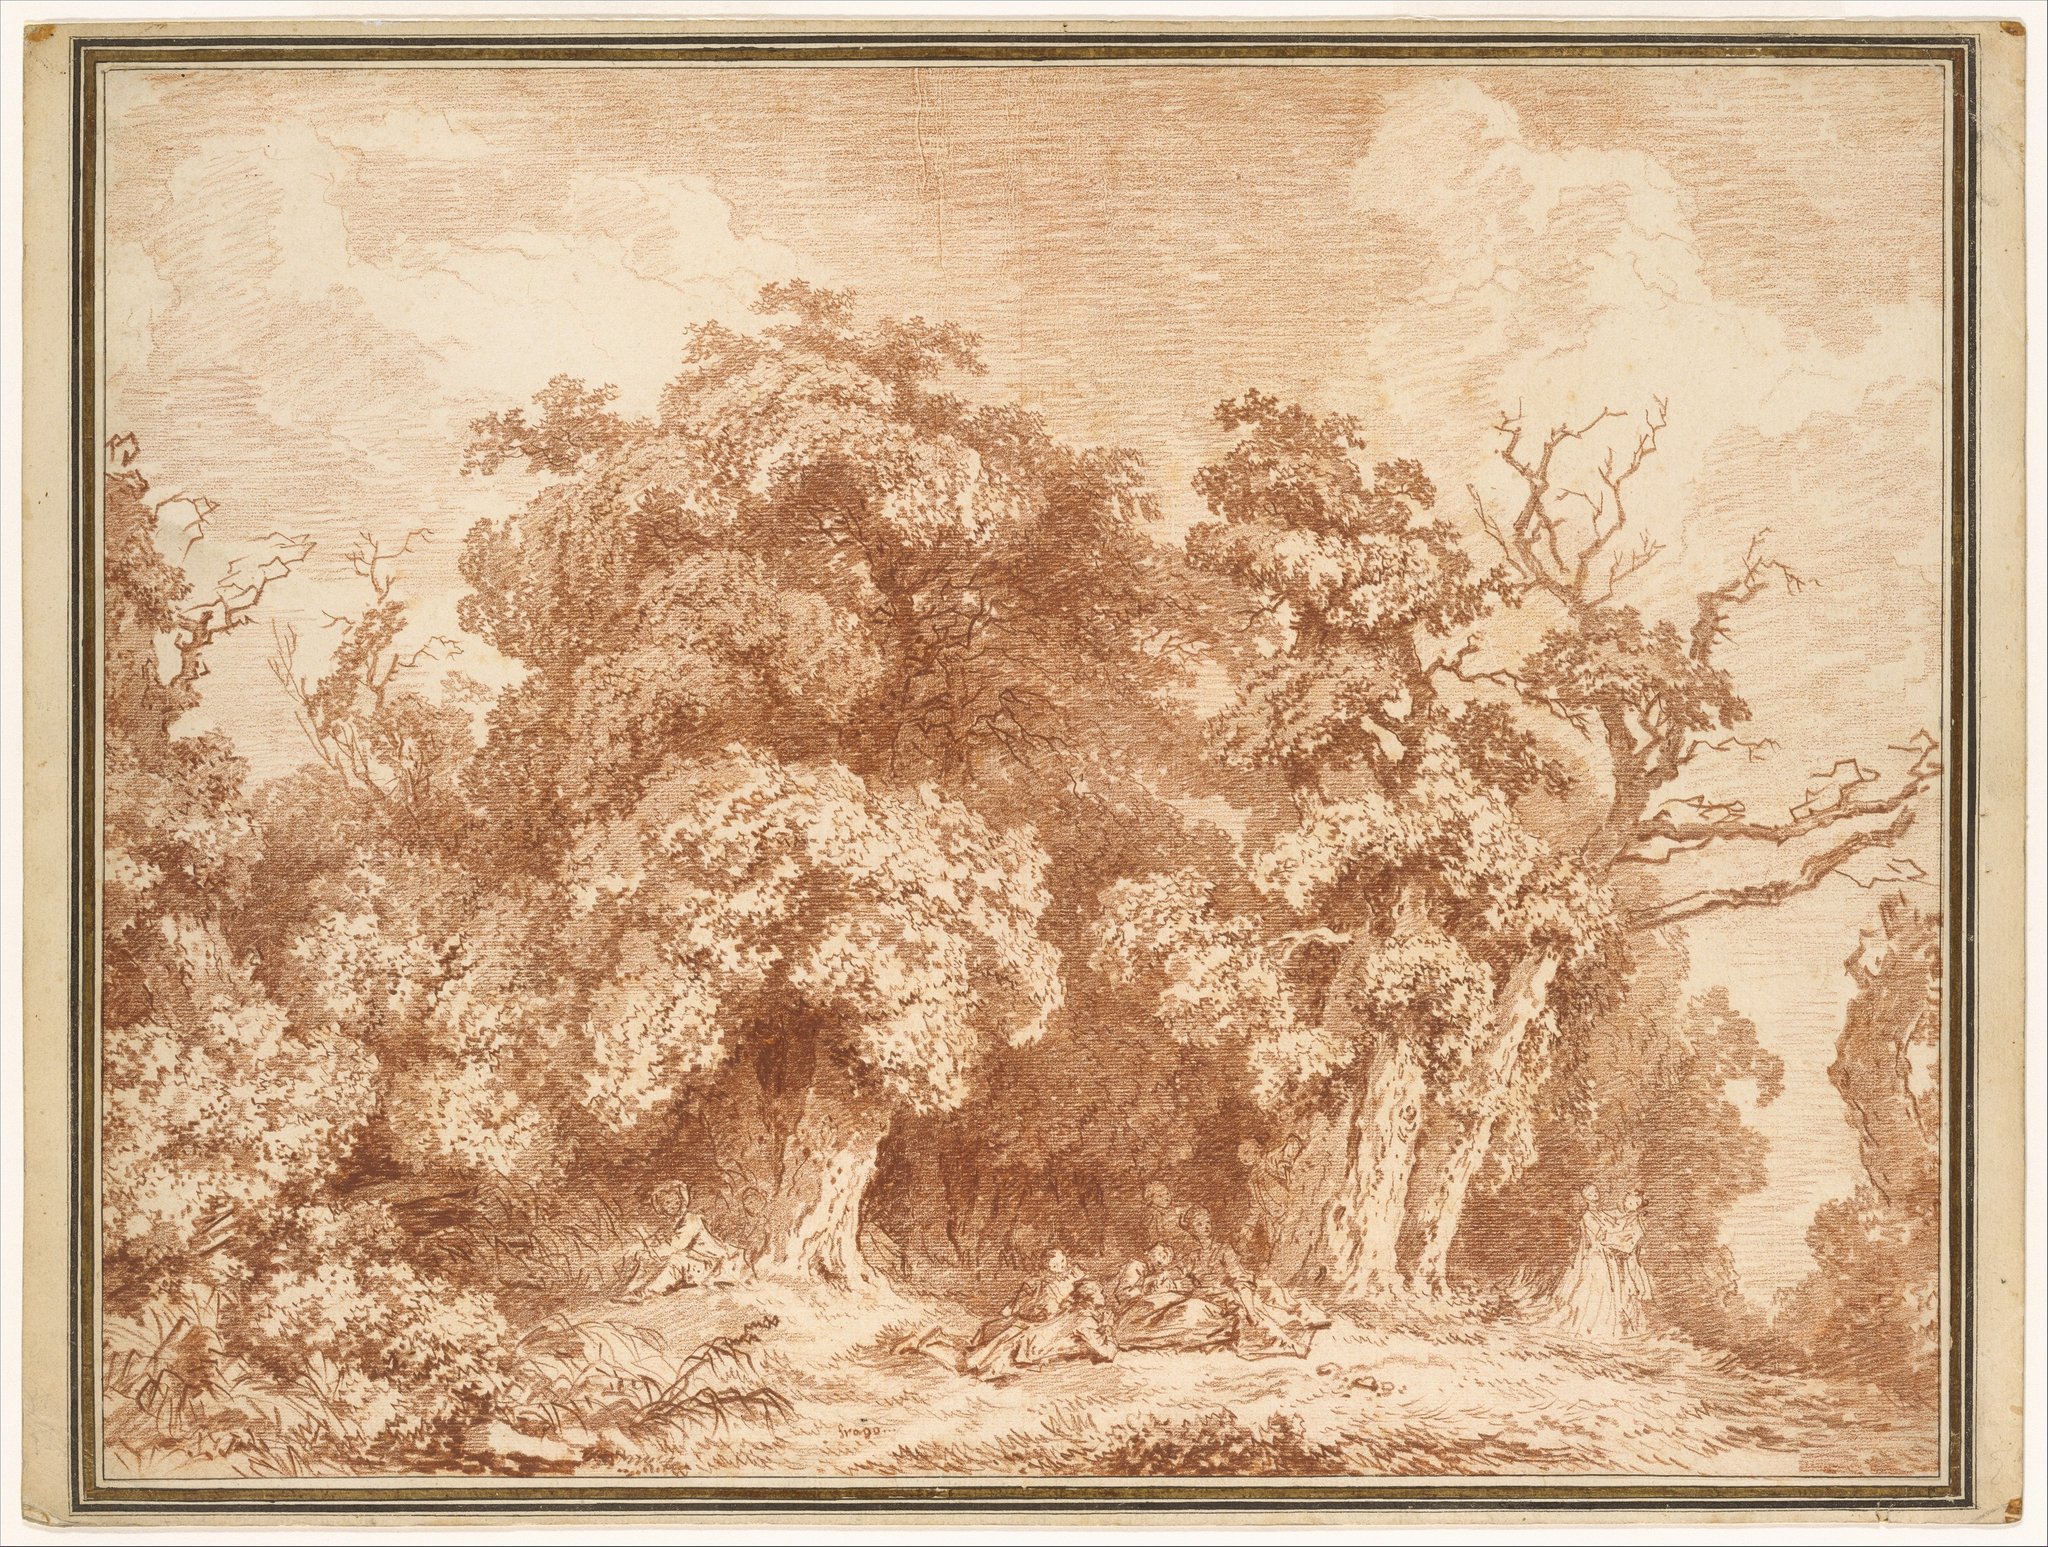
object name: drawing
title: A Gathering at Wood's Edge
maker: jean honoré fragonard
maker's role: artist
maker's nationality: french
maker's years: 1732-1806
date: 1770-1773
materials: chalk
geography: france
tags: forests,landscapes